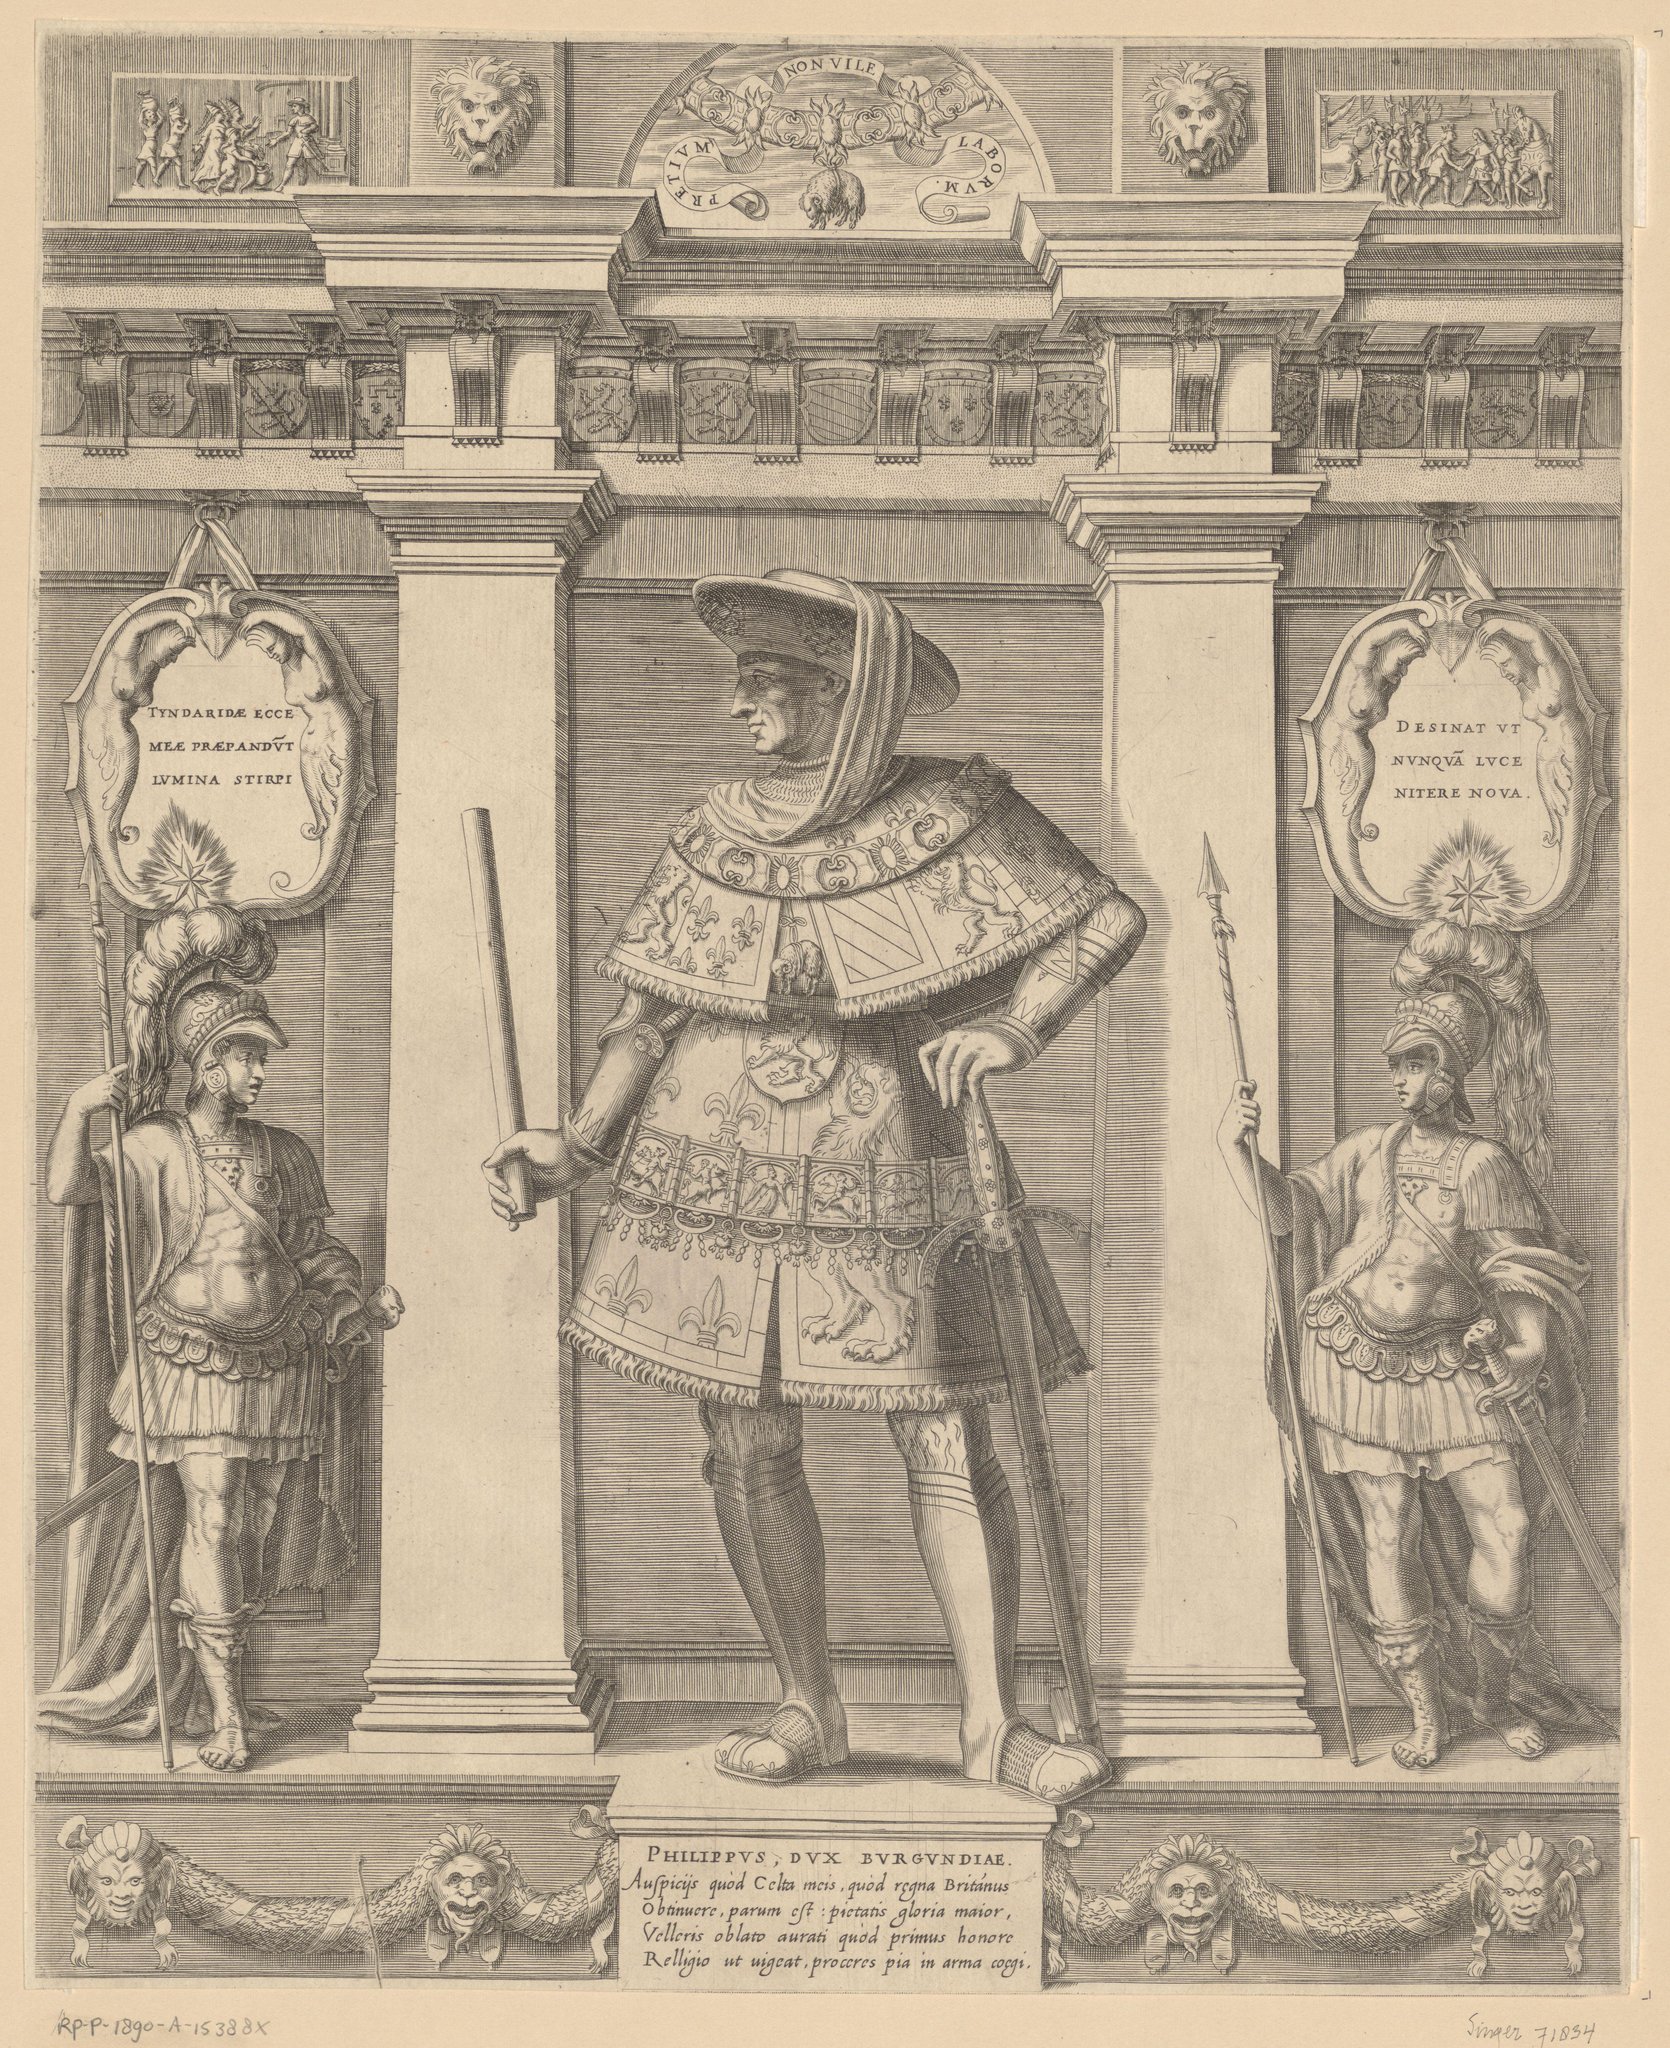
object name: print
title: Portretten van leden van het Oostenrijkse Huis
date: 1569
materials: paper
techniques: engraving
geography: italy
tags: philip iii the good, adult man, historical persons, knighthood order of the golden fleece, ruler, sovereign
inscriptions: collector's mark: Lugt 2228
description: Deze prent maakt deel uit van een reeks van 58 prenten. Het merendeel van de prenten bevat portretten van 74 leden van het Oostenrijkse Huis, naar tekeningen door Francesco Terzio, die deels getekend zijn naar de 28 levensgrote bronzen beelden die rond de cenotaaf van Maximiliaan I in de Hofkirche te Innsbruck staan.